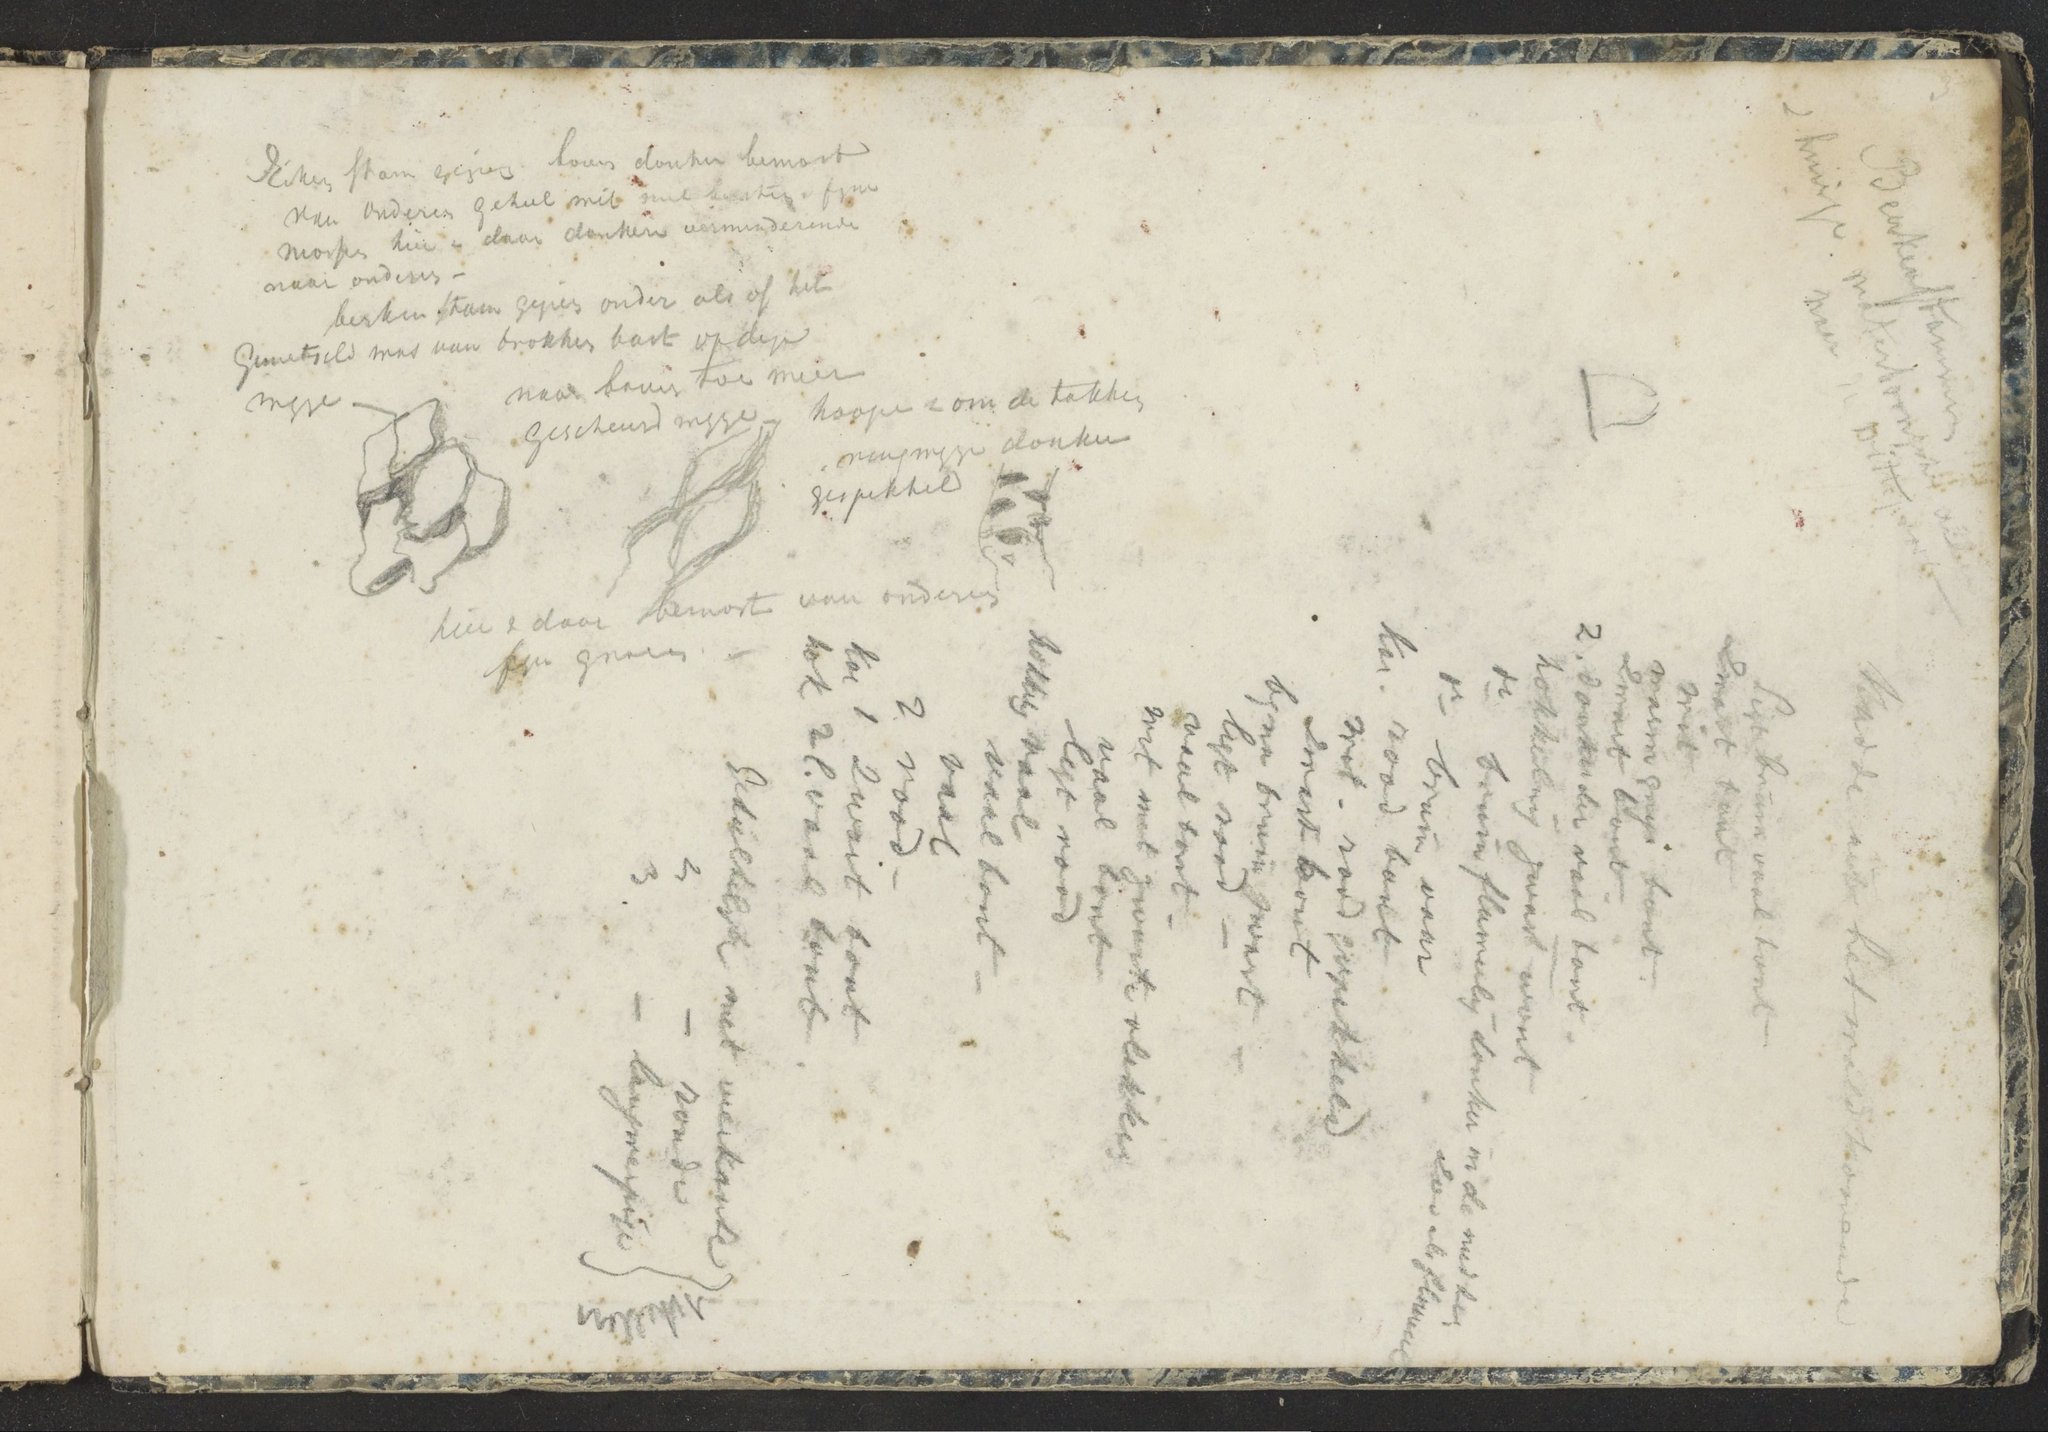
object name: sketchbook leaf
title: Botanische studies en een beukenstam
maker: johannes tavenraat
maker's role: draughtsman, painter, print maker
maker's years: 1809-1881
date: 1843-1857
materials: paper, pencil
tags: trees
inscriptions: annotation: ‘[...]’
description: Achterste schutblad uit een schetsboek met 44 bladen.